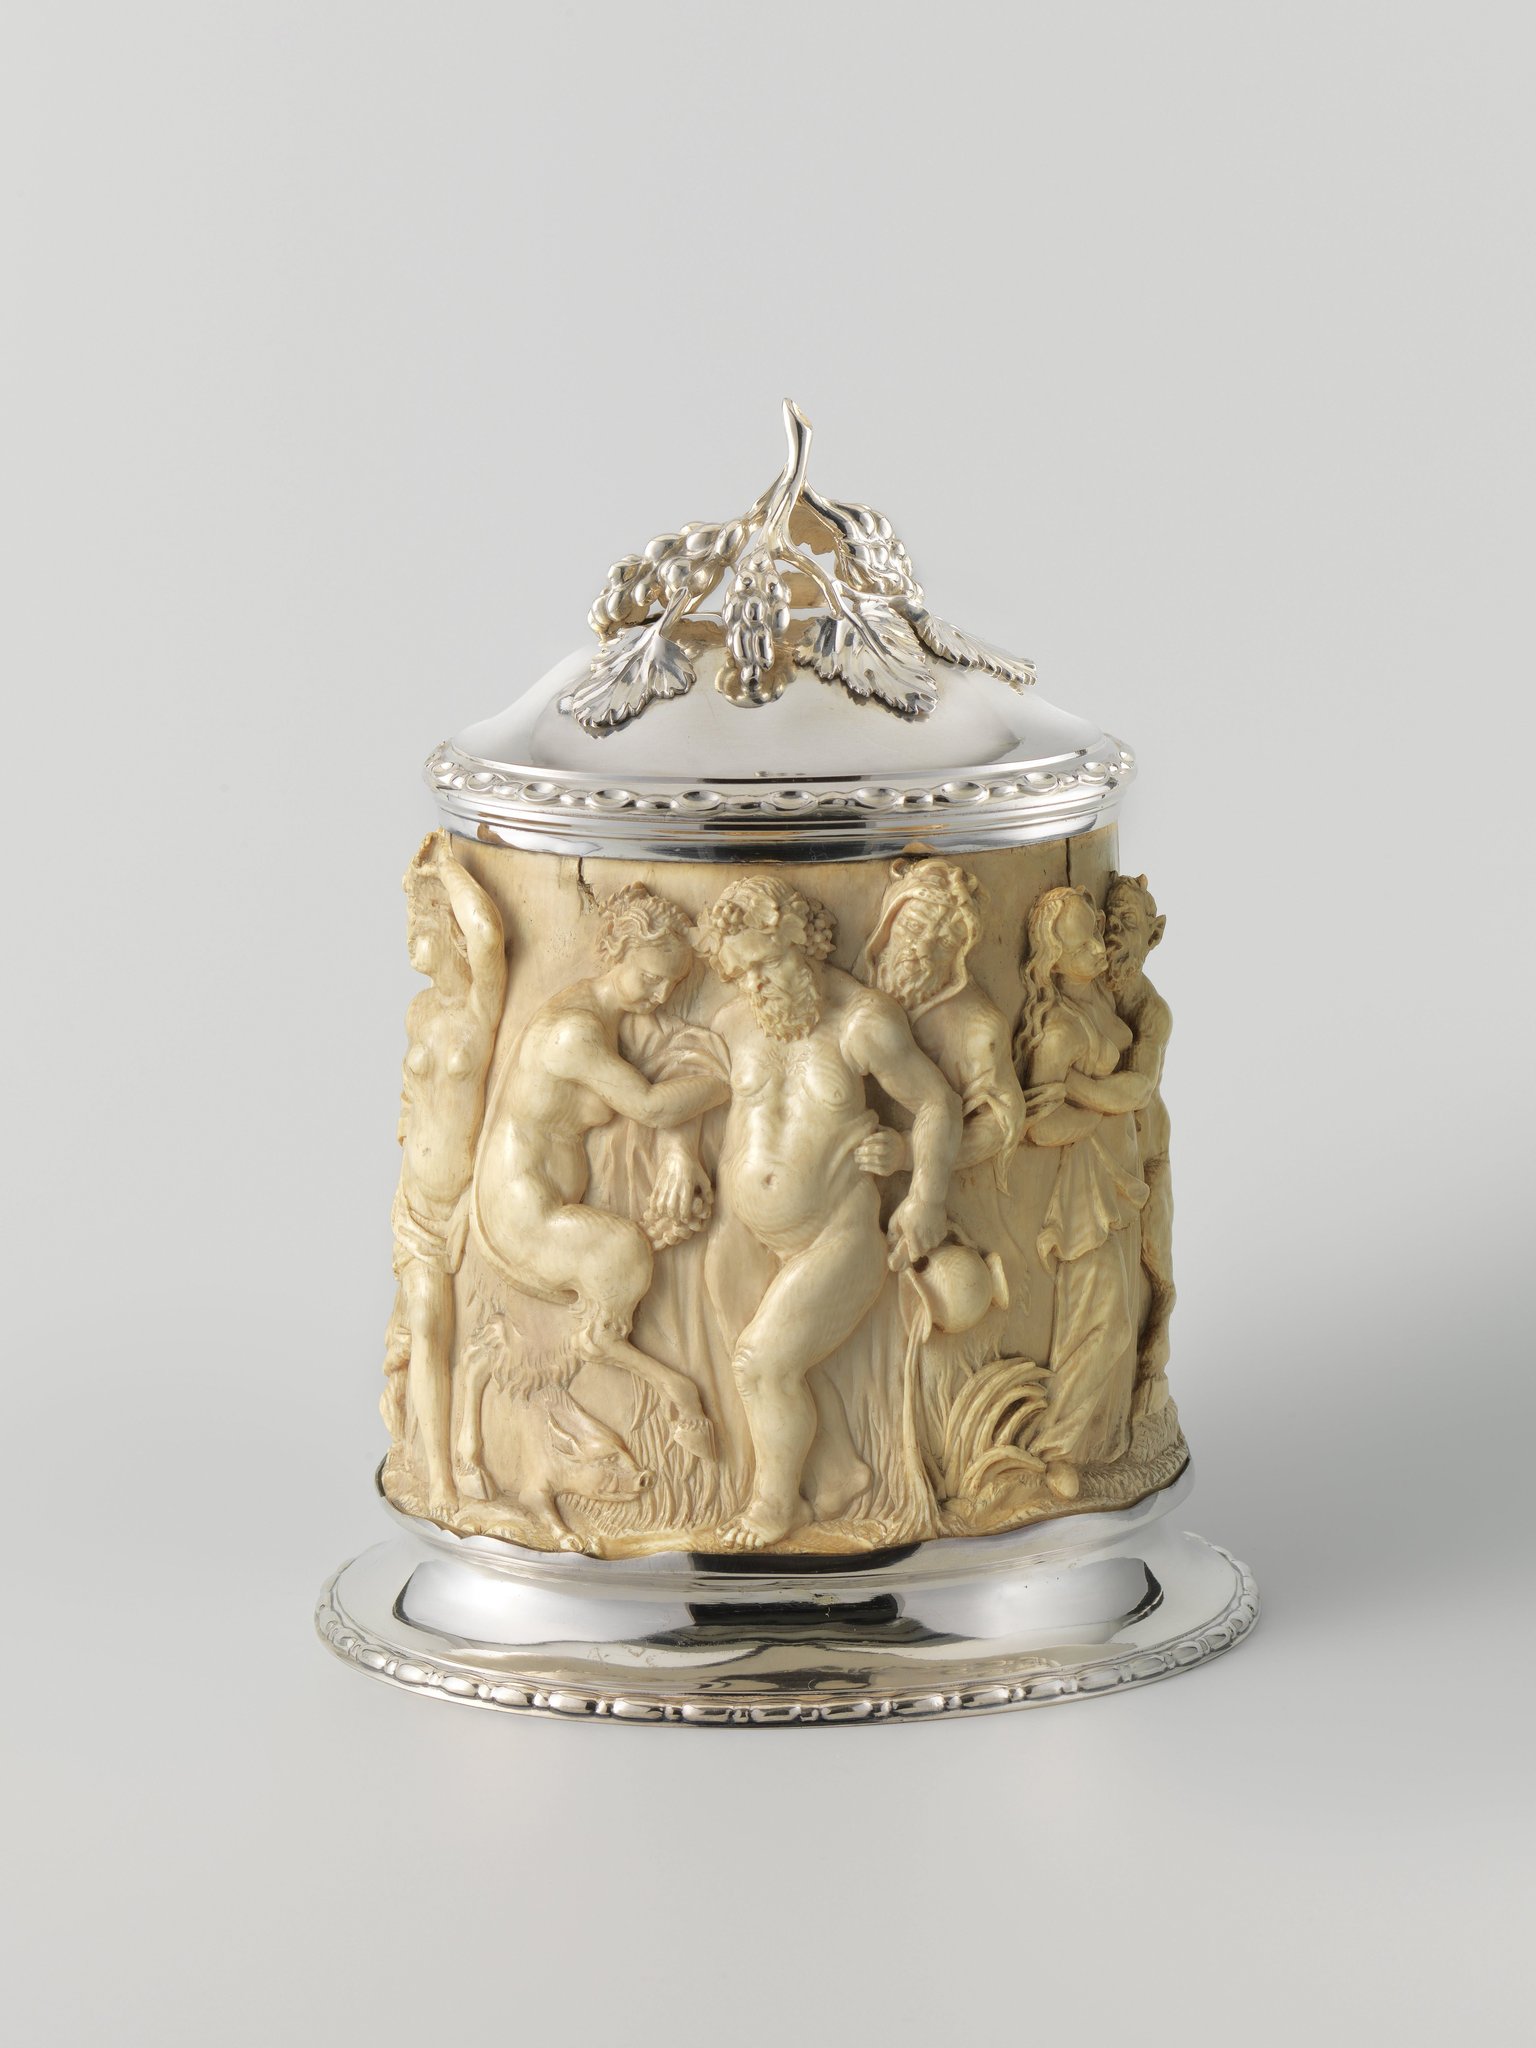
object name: drinkkan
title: Bachanal (ceremonial tankard)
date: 1771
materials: ivory, silver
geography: the hague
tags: triumph of silenus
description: Ovaal cilindervormige drinkkan van zilver. De cilinder is bekleed met een gebeeldhouwd basreliëf in ivoor, voorstellende de triomf van Silenus.